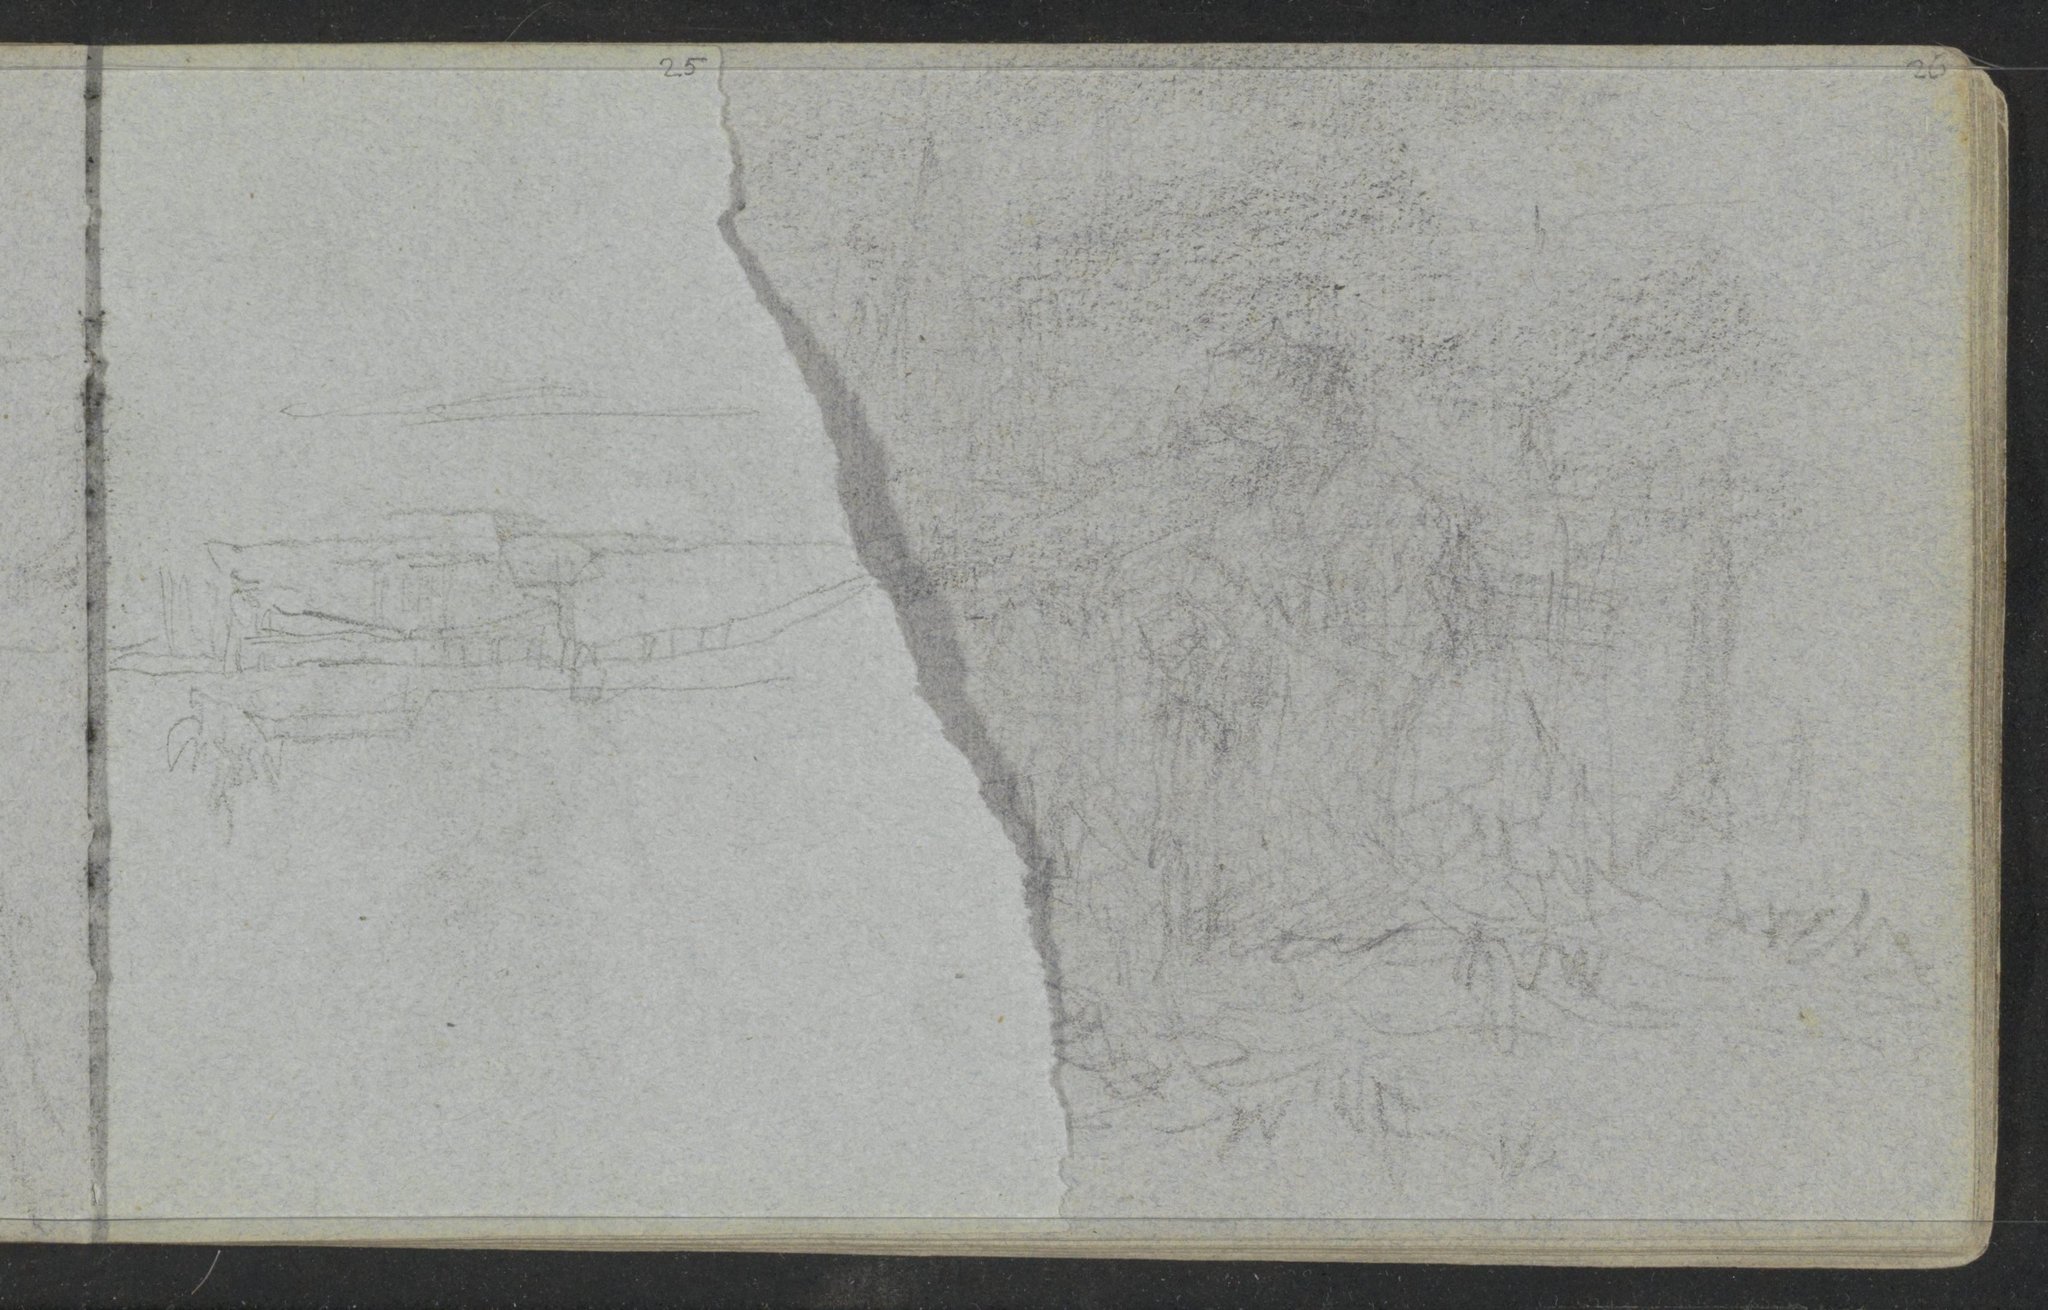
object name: sketchbook leaf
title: Roeiboot aan een waterkant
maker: matthijs maris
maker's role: draughtsman, painter, print maker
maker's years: 1839-1917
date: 1849-1917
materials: paper, pencil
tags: rowing-boat, canoe, etc.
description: Blad 25 recto uit een schetsboek met 35 bladen.